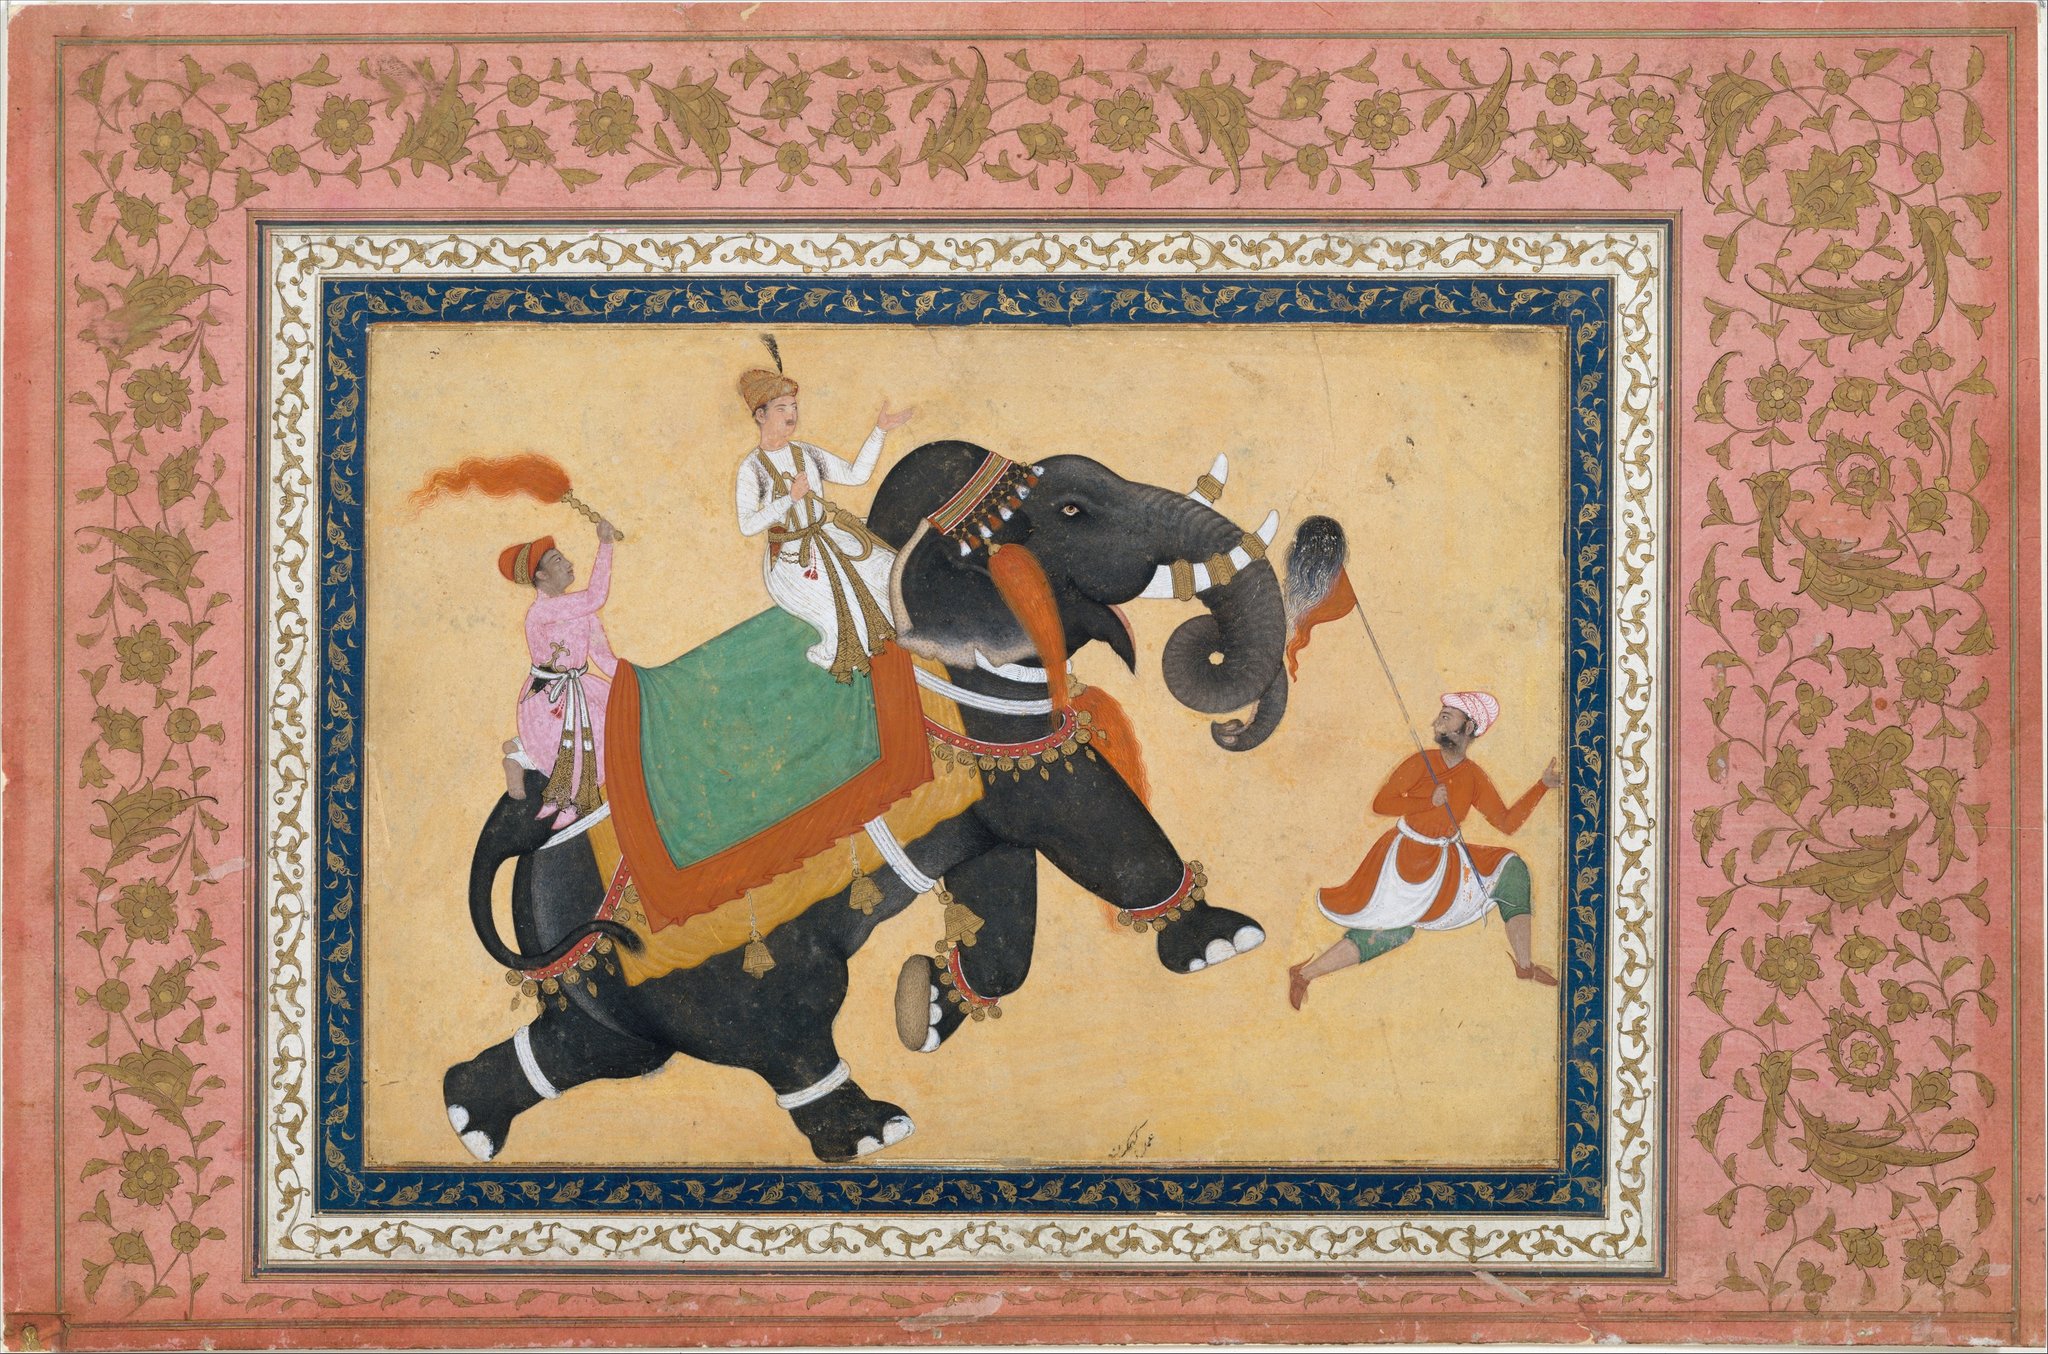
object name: illustrated album leaf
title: Prince Riding an Elephant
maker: khem karan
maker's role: artist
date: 1501-1700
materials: gold, ink, paper, watercolor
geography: india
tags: princes,men,elephants